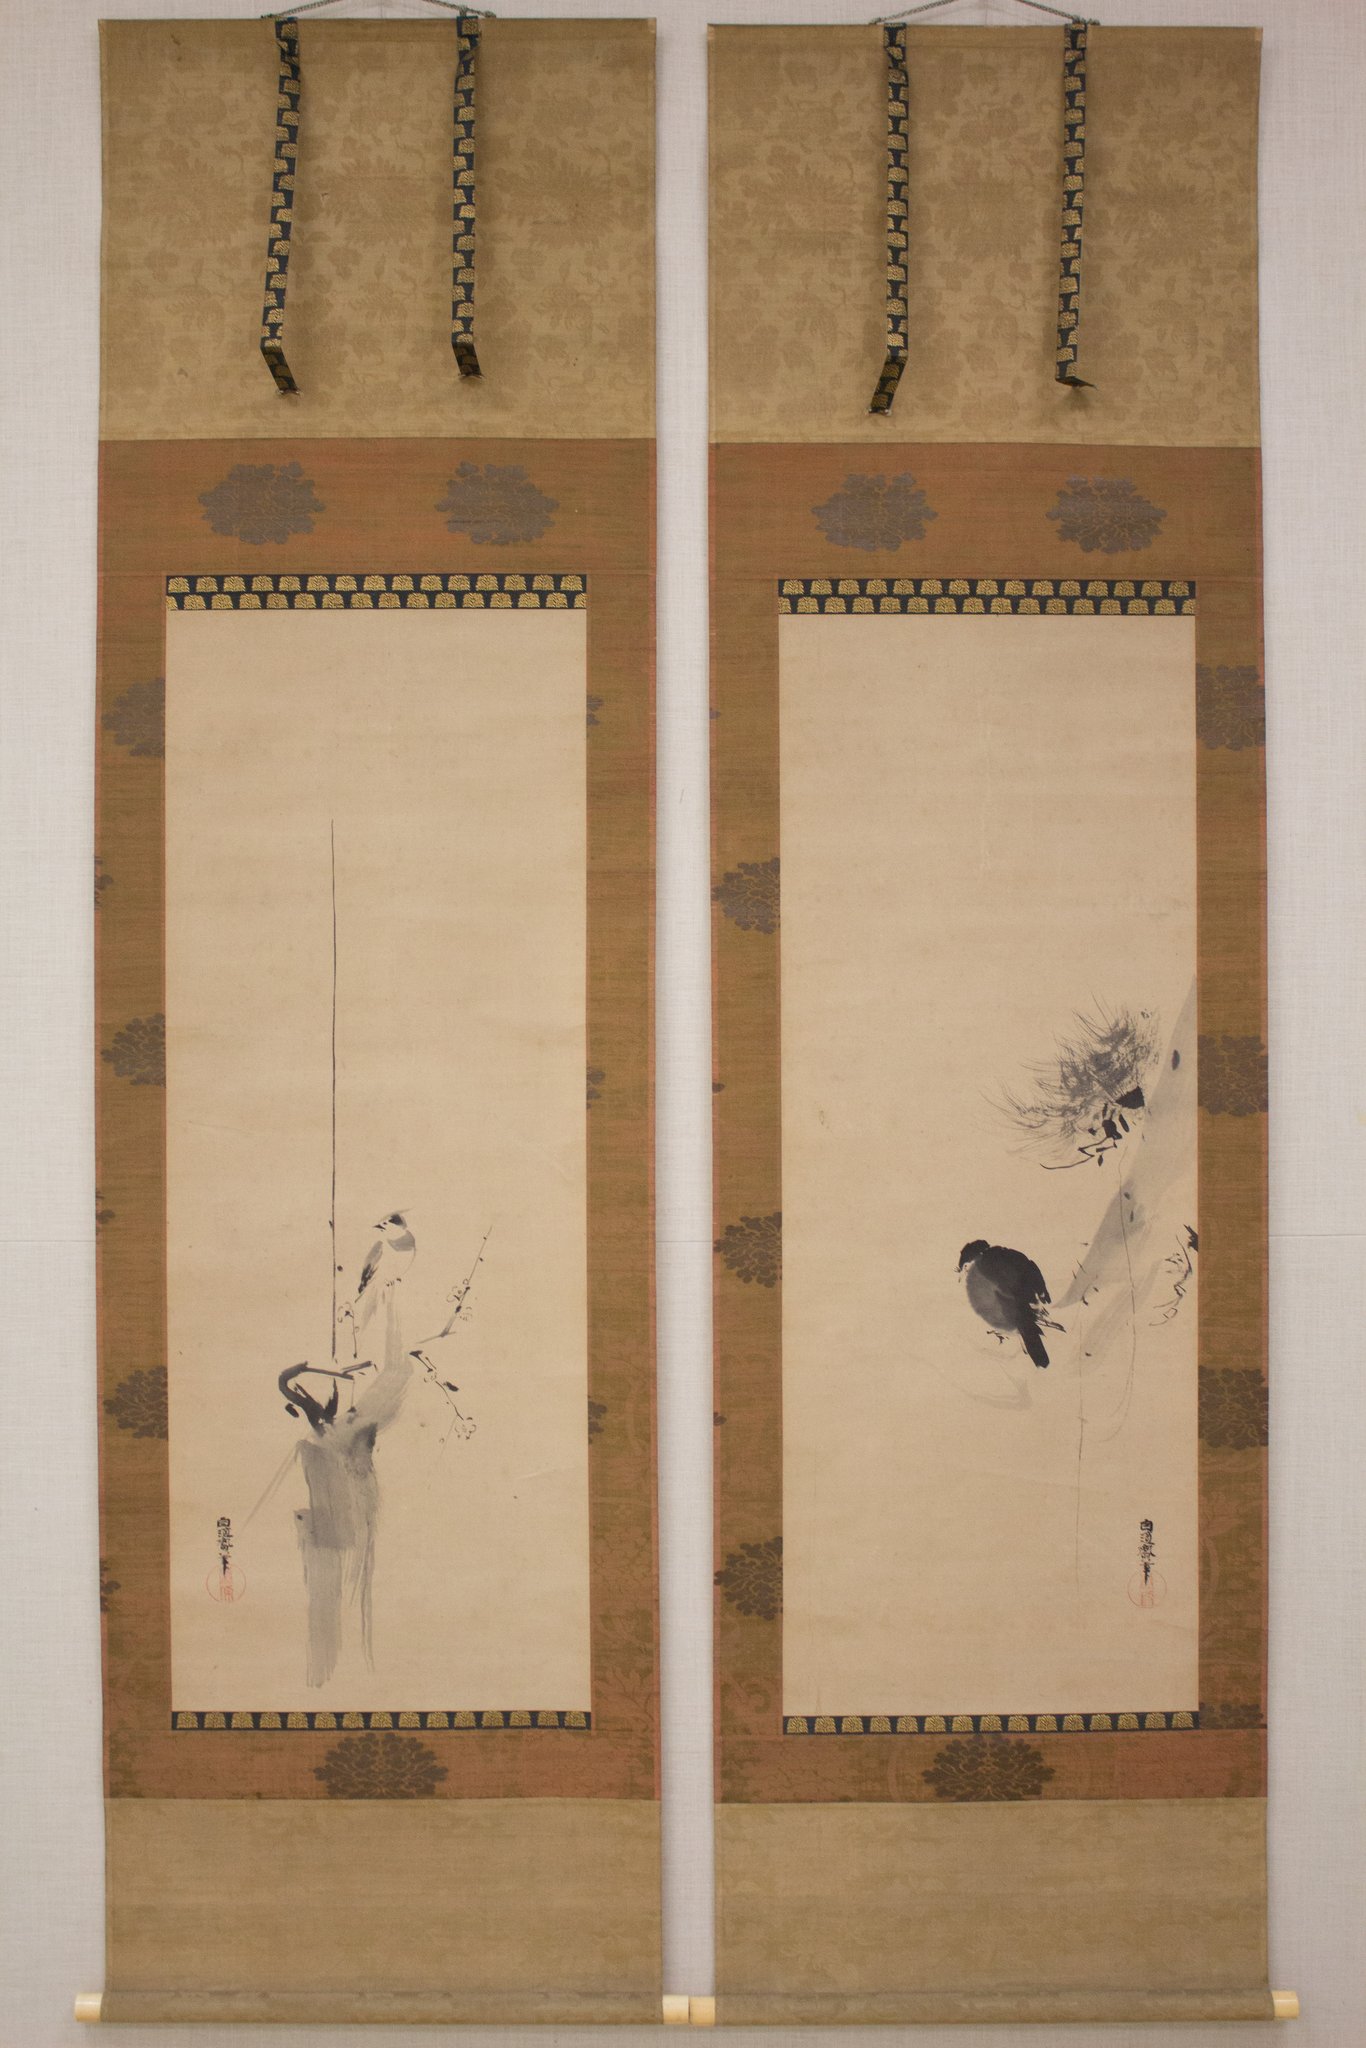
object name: hanging scroll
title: Crested Bird on Stump of Plum Tree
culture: japanese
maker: kano naonobu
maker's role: artist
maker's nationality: japanese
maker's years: 1607-1650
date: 1607-1650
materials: ink, paper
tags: birds